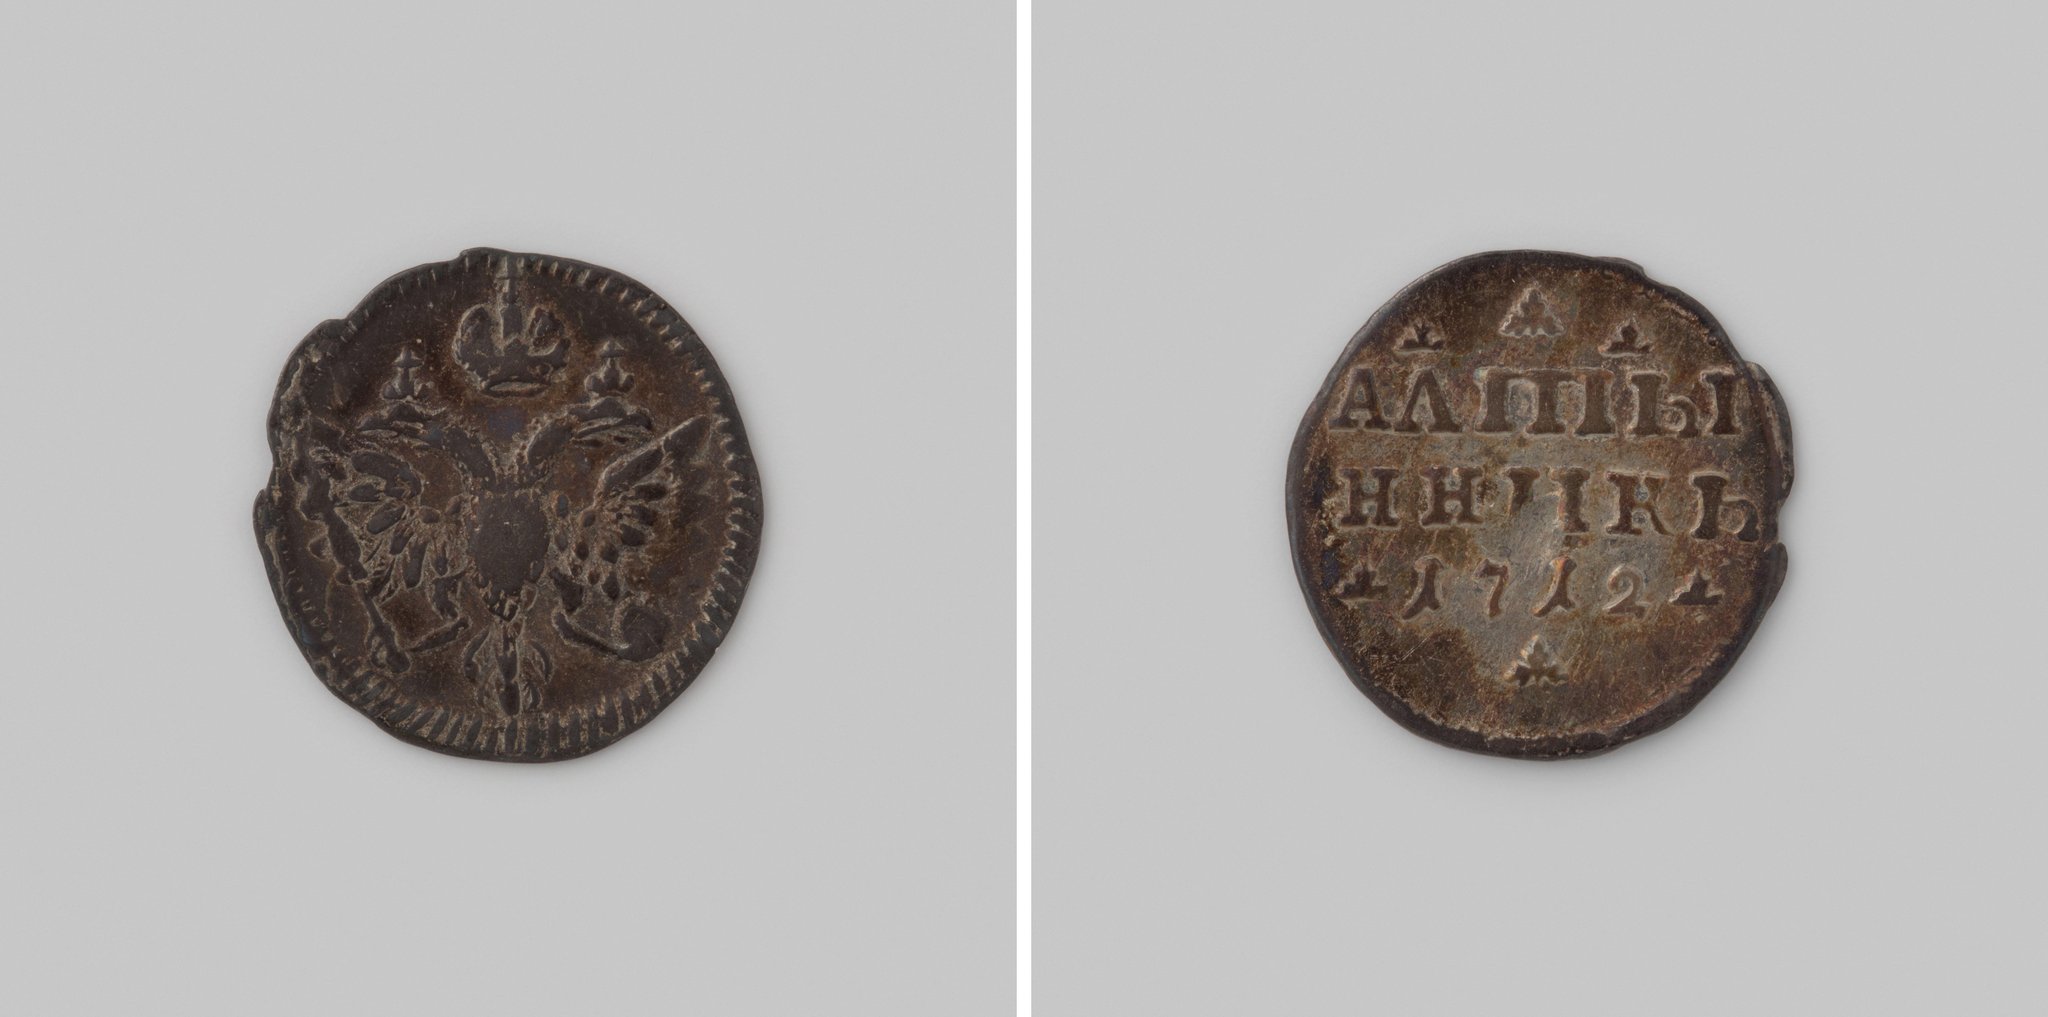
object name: coin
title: Altinnik of 3 kopeken uit Rusland van tsaar Peter I,1712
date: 1712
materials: silver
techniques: striking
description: Zilveren munt. Voorzijde: dubbelkoppige gekroonde adelaar met gespreide vleugels en met in zijn poten scepter en bol met daarop kruis. Boven de adelaar een kroon. Keerzijde: in twee regels de waarde-aanduiding: altinnik, waaronder jaartal. Gladde rand.